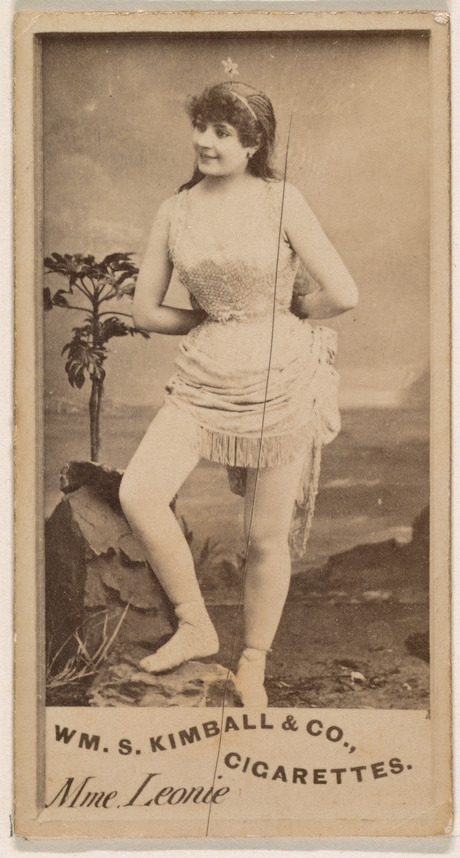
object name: photograph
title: Mme. Leonie, from the Actresses series (N203) issued by Wm. S. Kimball & Co.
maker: william s. kimball & company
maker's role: publisher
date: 1889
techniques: color lithograph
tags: portraits,women,actresses